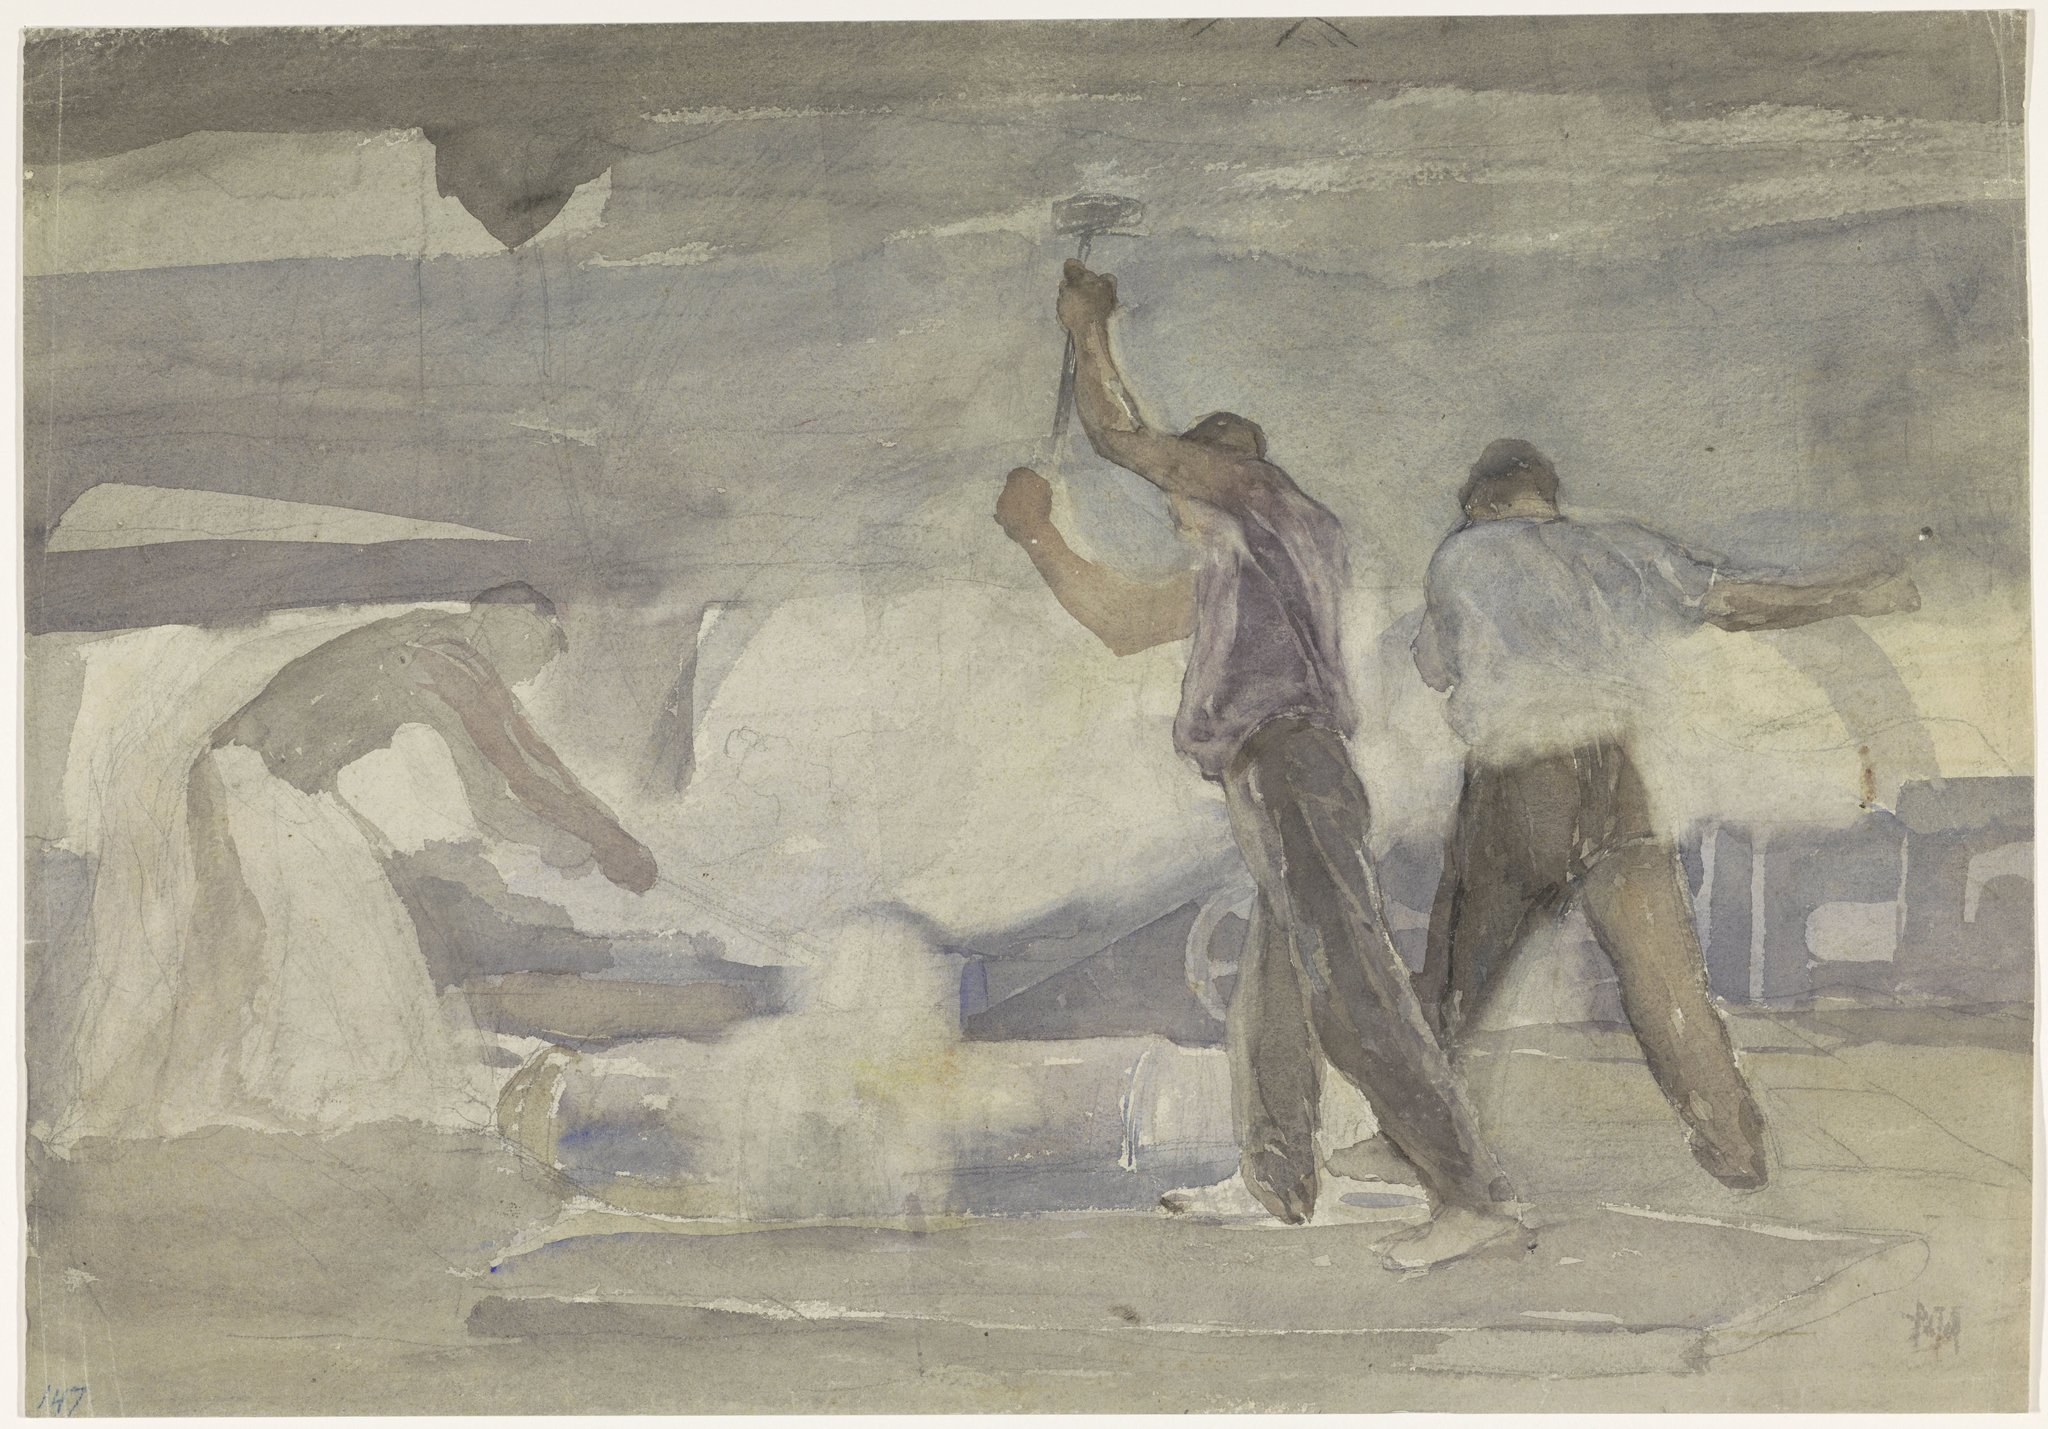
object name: watercolor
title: Smederij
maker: pieter de josselin de jong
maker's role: draughtsman, painter, print maker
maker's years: 1861-1906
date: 1871-1906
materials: paper, pencil, watercolor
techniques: brush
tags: iron and steel industry